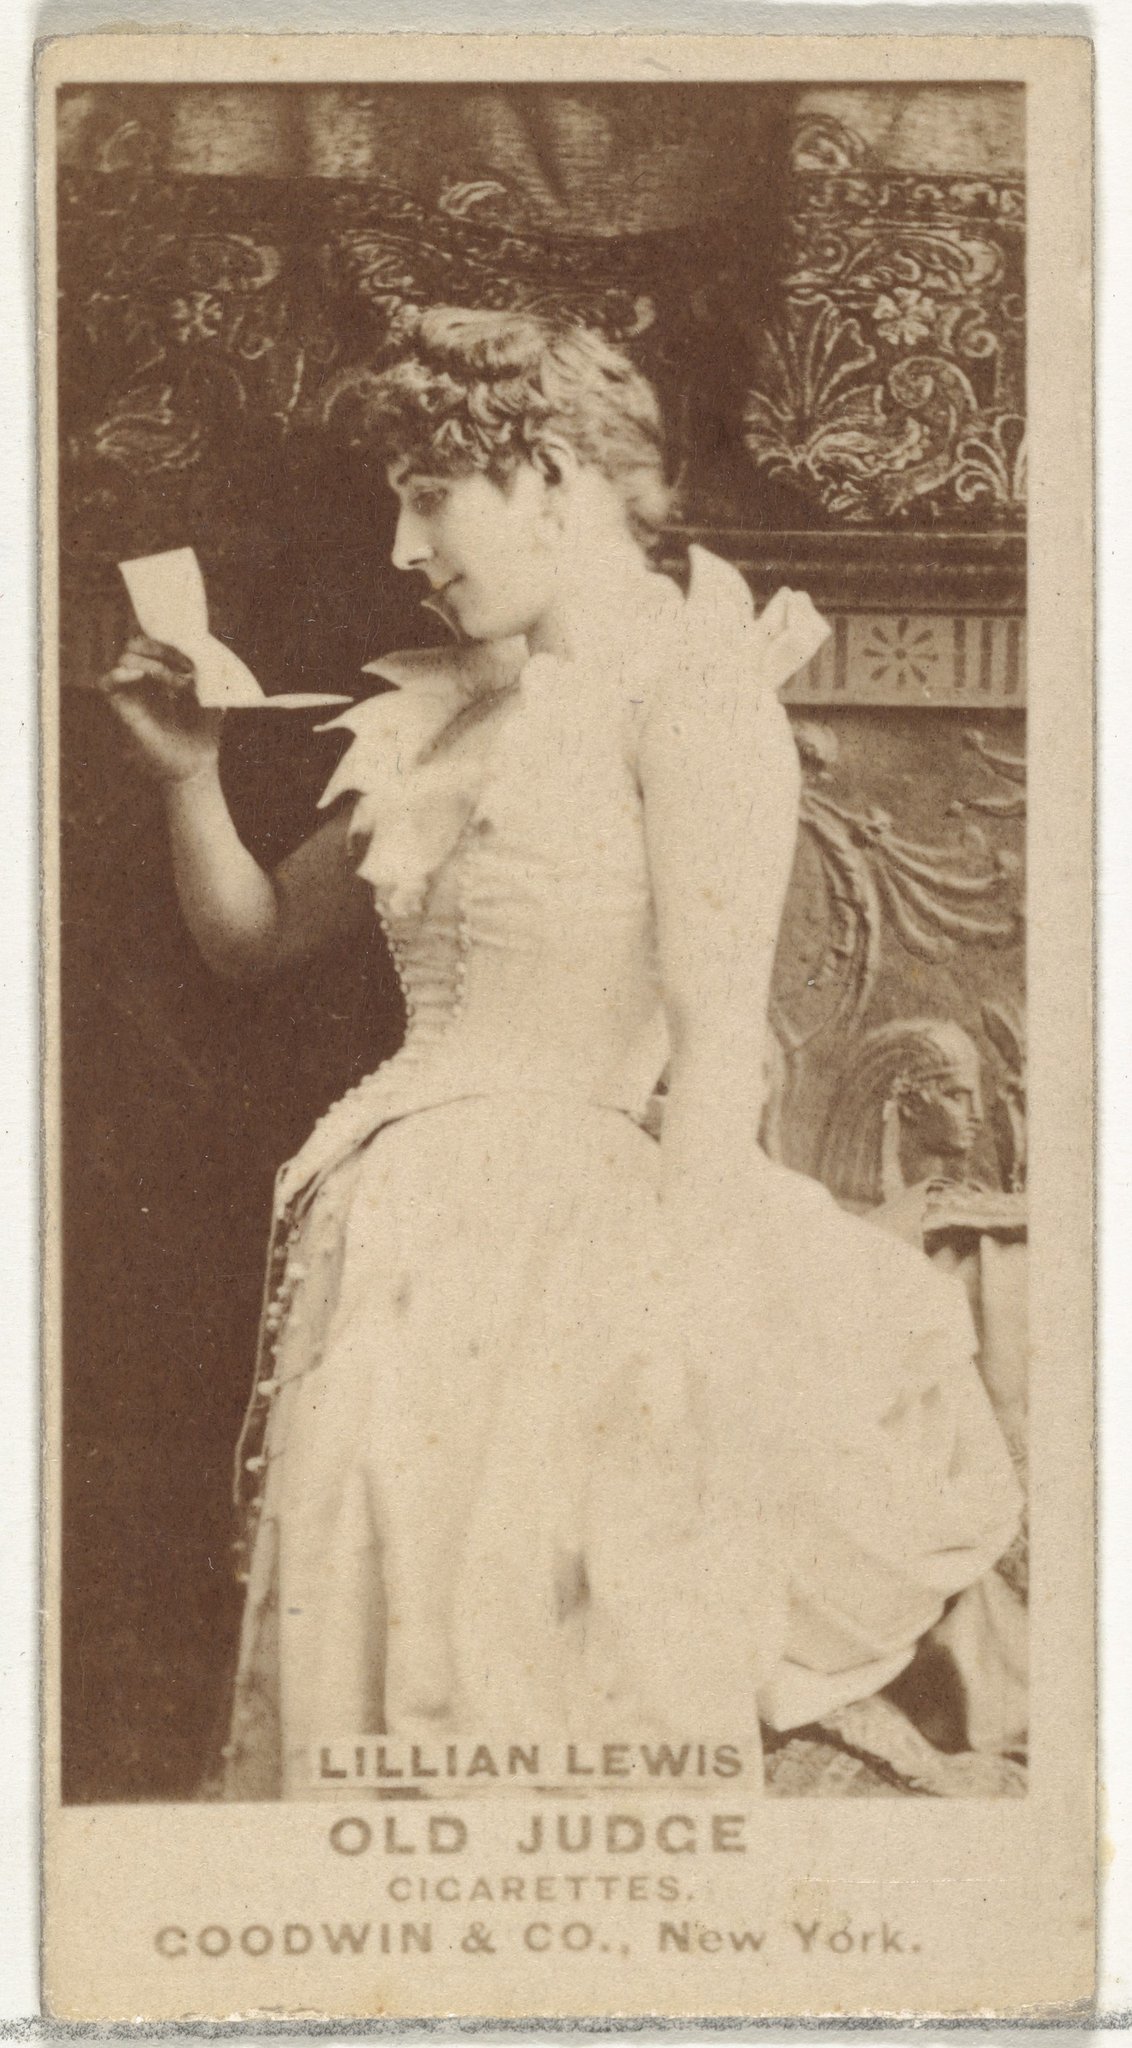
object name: photograph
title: Lillian Lewis, from the Actors and Actresses series (N171) for Old Judge Cigarettes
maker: goodwin & company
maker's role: publisher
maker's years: 1850-1950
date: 1886-1890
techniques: albumen silver print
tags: portraits,women,reading,actresses